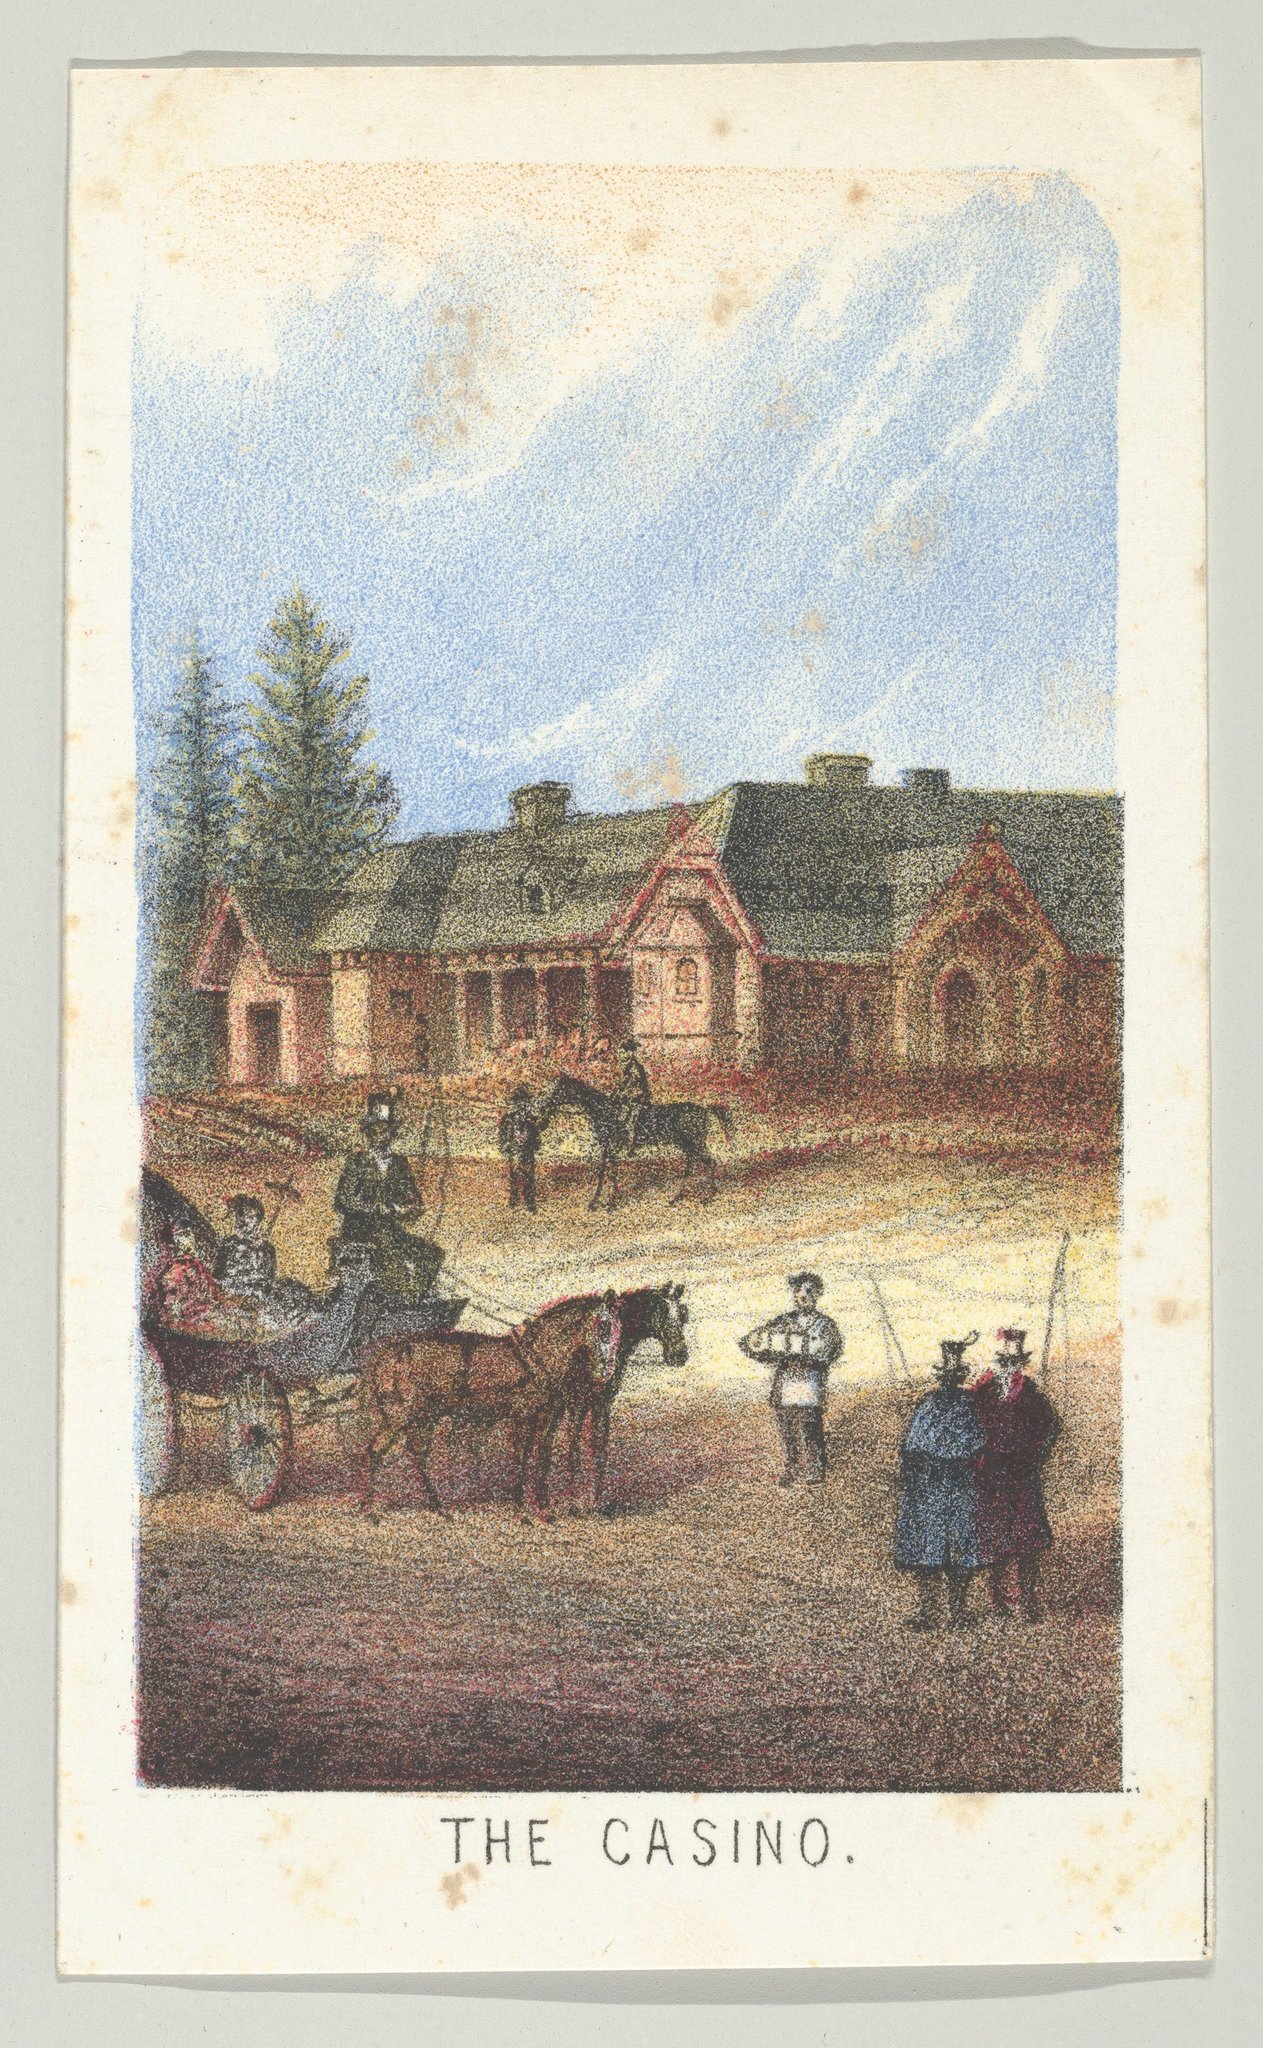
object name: print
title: The Casino, from the series, Views in Central Park, New York, Part 3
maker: louis prang & co.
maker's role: publisher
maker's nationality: american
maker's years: 1800-1950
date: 1864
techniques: lithograph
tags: buildings,horses,carriages